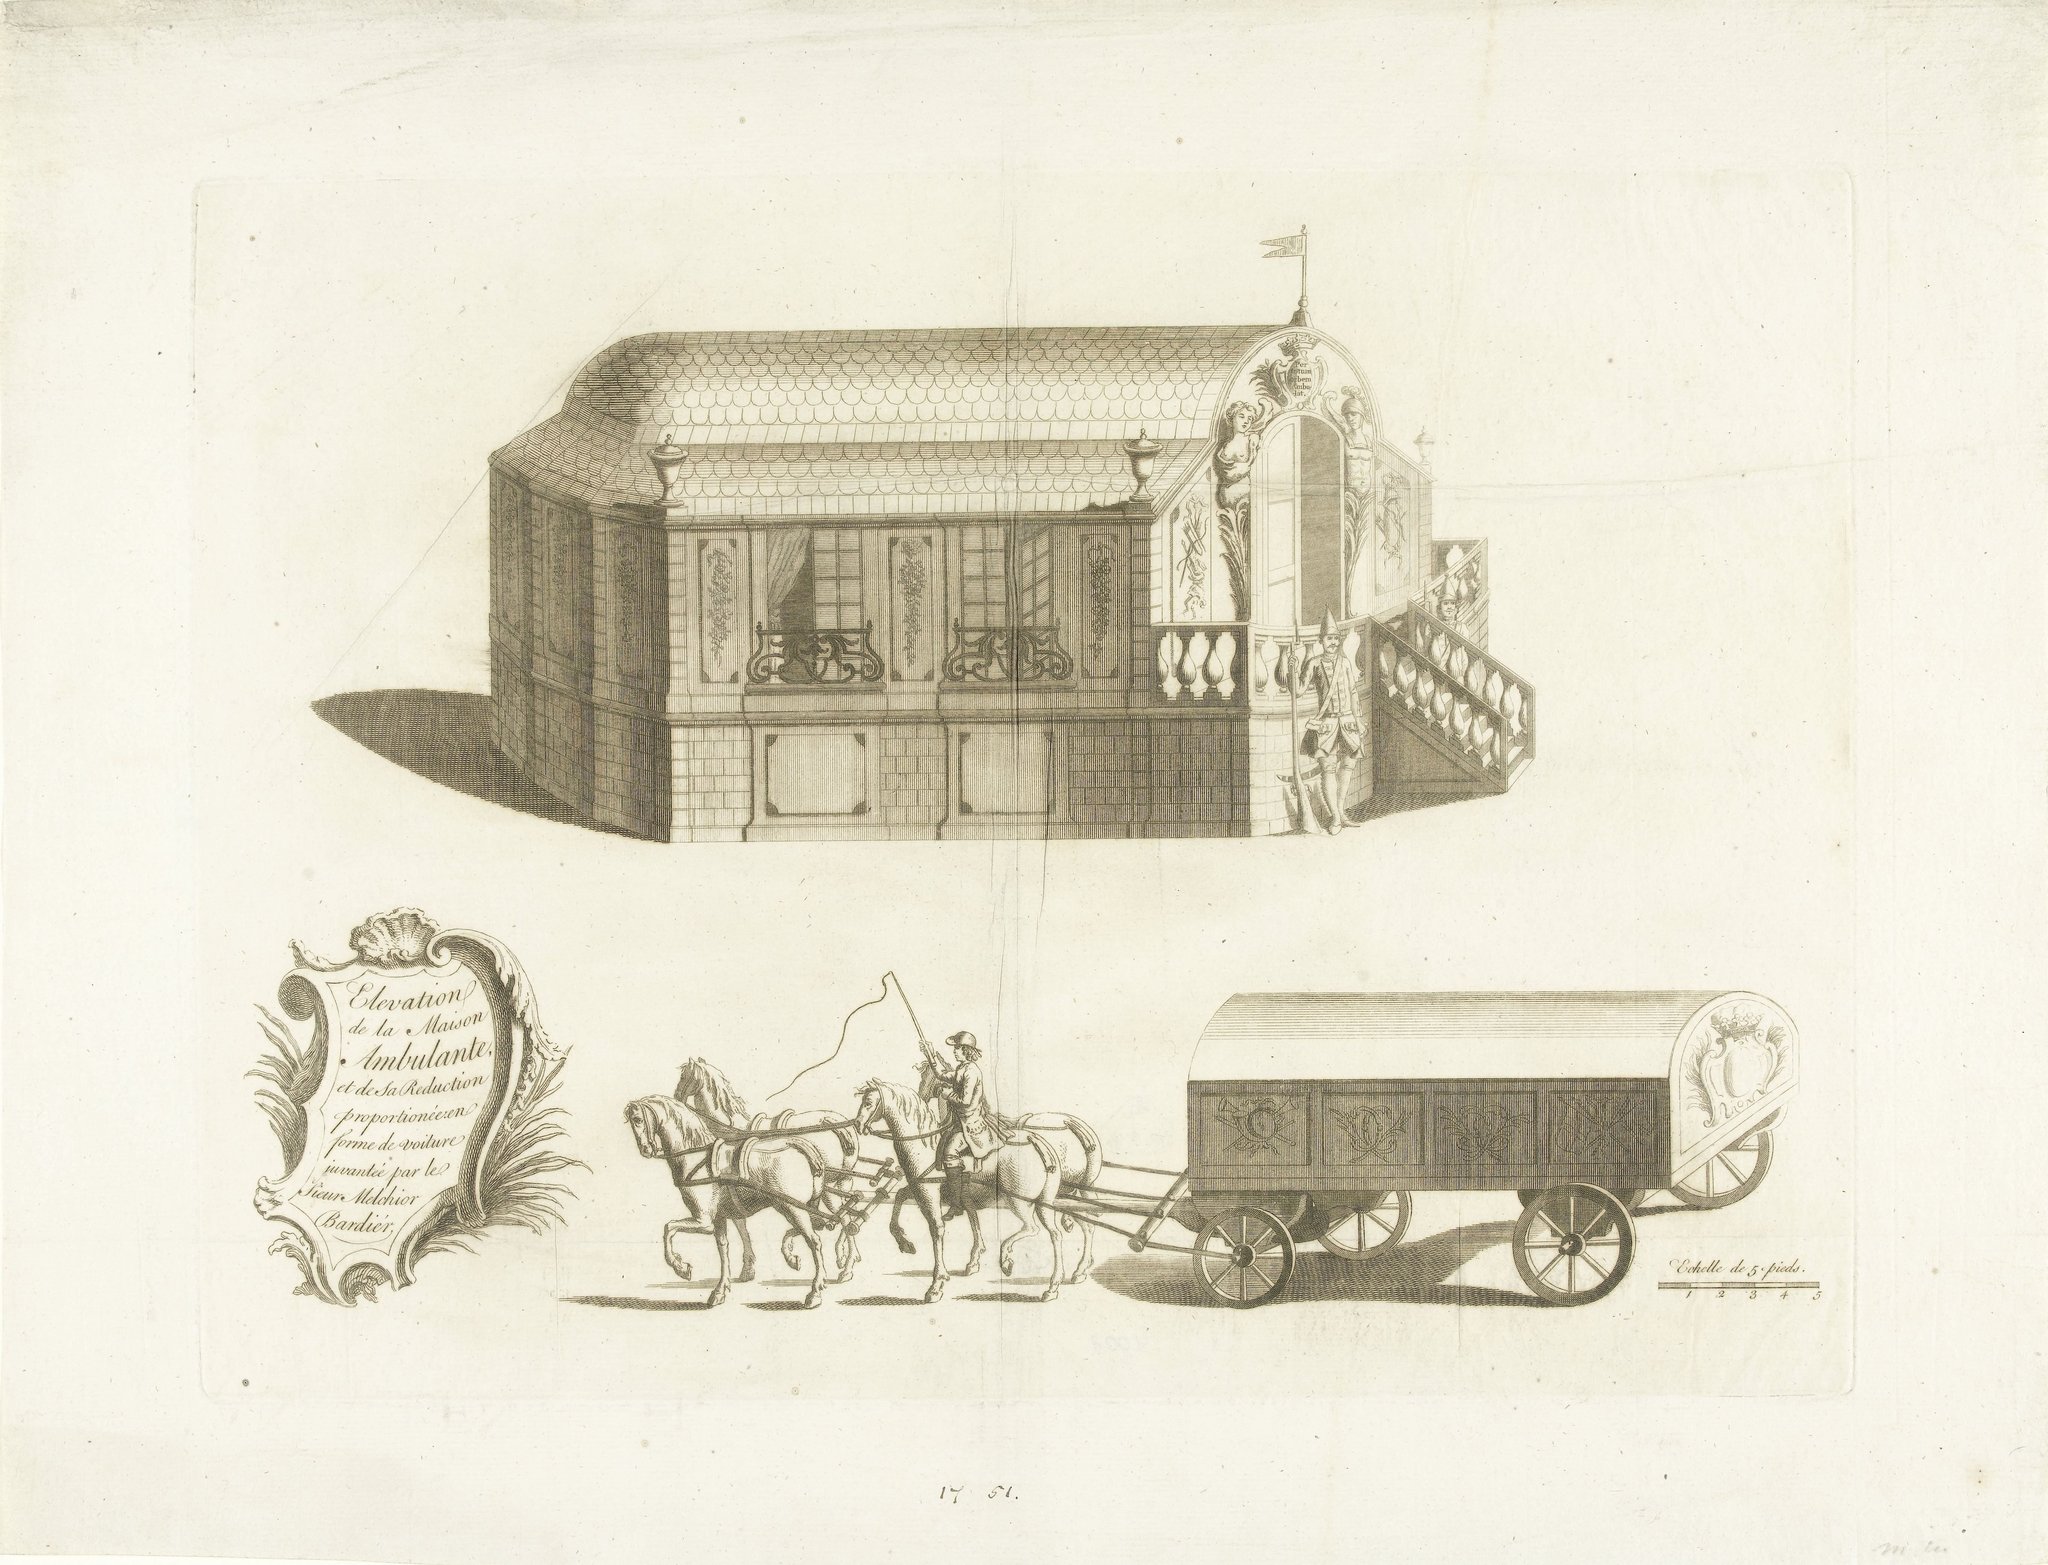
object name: print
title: Uitvinding van een mobiel huis, 1751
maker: Anonymous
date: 1751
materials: paper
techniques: engraving, etching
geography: northern netherlands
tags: caravan (trailer)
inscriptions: collector's mark: Lugt 2228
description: Blad met twee voorstellingen van de uitvinding van een mobiel huis door Melchior Bardier, 1751. Bovenaan het huis in gemonteerde staat, met een soldaat die wacht houdt bij de deur. Onderaan de vervoer van het opgevouwen huis met een paard en wagen. Het huis was te zien in het Haagse Bos in 1751. Bij de prent behoort een beschrijving in Nederlands en Frans.